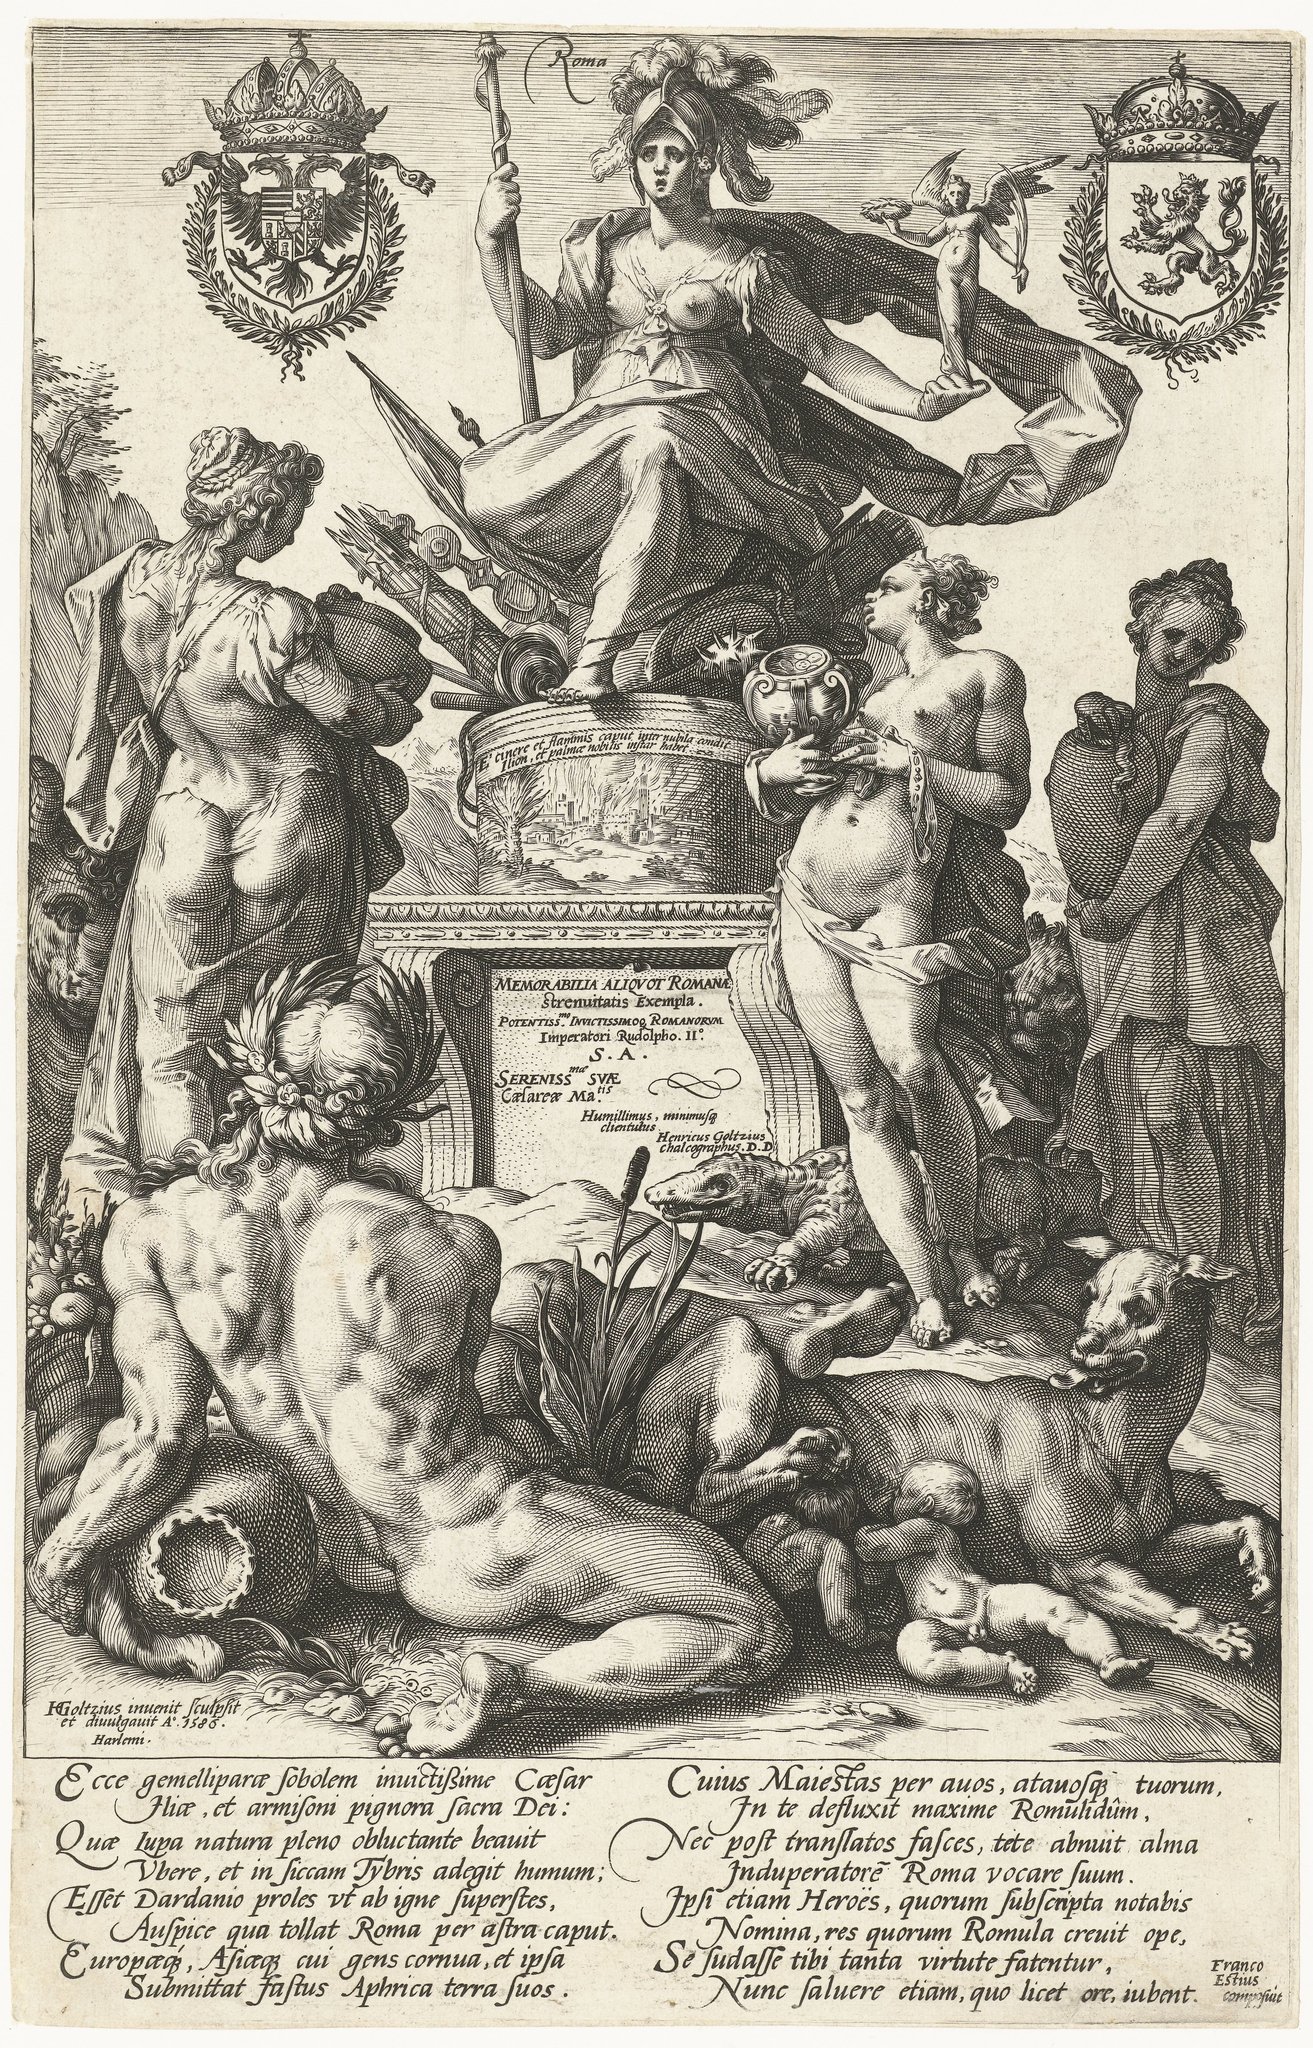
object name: print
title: De Romeinse helden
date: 1586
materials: paper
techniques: engraving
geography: haarlem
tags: europe represented allegorically; 'europa' (ripa), asia represented allegorically; 'asia' (ripa), africa represented allegorically; 'africa' (ripa), romulus and remus are washed ashore and suckled by a she-wolf; 'lupa romana', rome (one of the four world empires)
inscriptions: collector's mark: Lugt 240, signature: ‘HGoltzius inuenit sculpsit/et diuulgauit Ao. 1586./Harlemi’, caption: ‘Ecce gemelliparae...licet ore, iubent’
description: De godin Rome ('Roma'), gezeten op een zetel van wapens op een sokkel, in haar linkerhand een beeldje van de godin van de overwinning. Bij de sokkel staan een vrouw met een os (Europa), een vrouw met een leeuw (Azië) en een vrouw met een krokodil (Afrika). Op de voorgrond ligt de stroomgod van de Tiber en de wolvin die Romulus en Remus zoogt. Onder de voorstelling twee coupletten van acht versregels in Latijn. Titelprent voor een serie van tien prenten, bestaand uit een ongenummerde titelprent, acht genummerde voorstellingen van helden en een ongenummerde afsluitende prent.